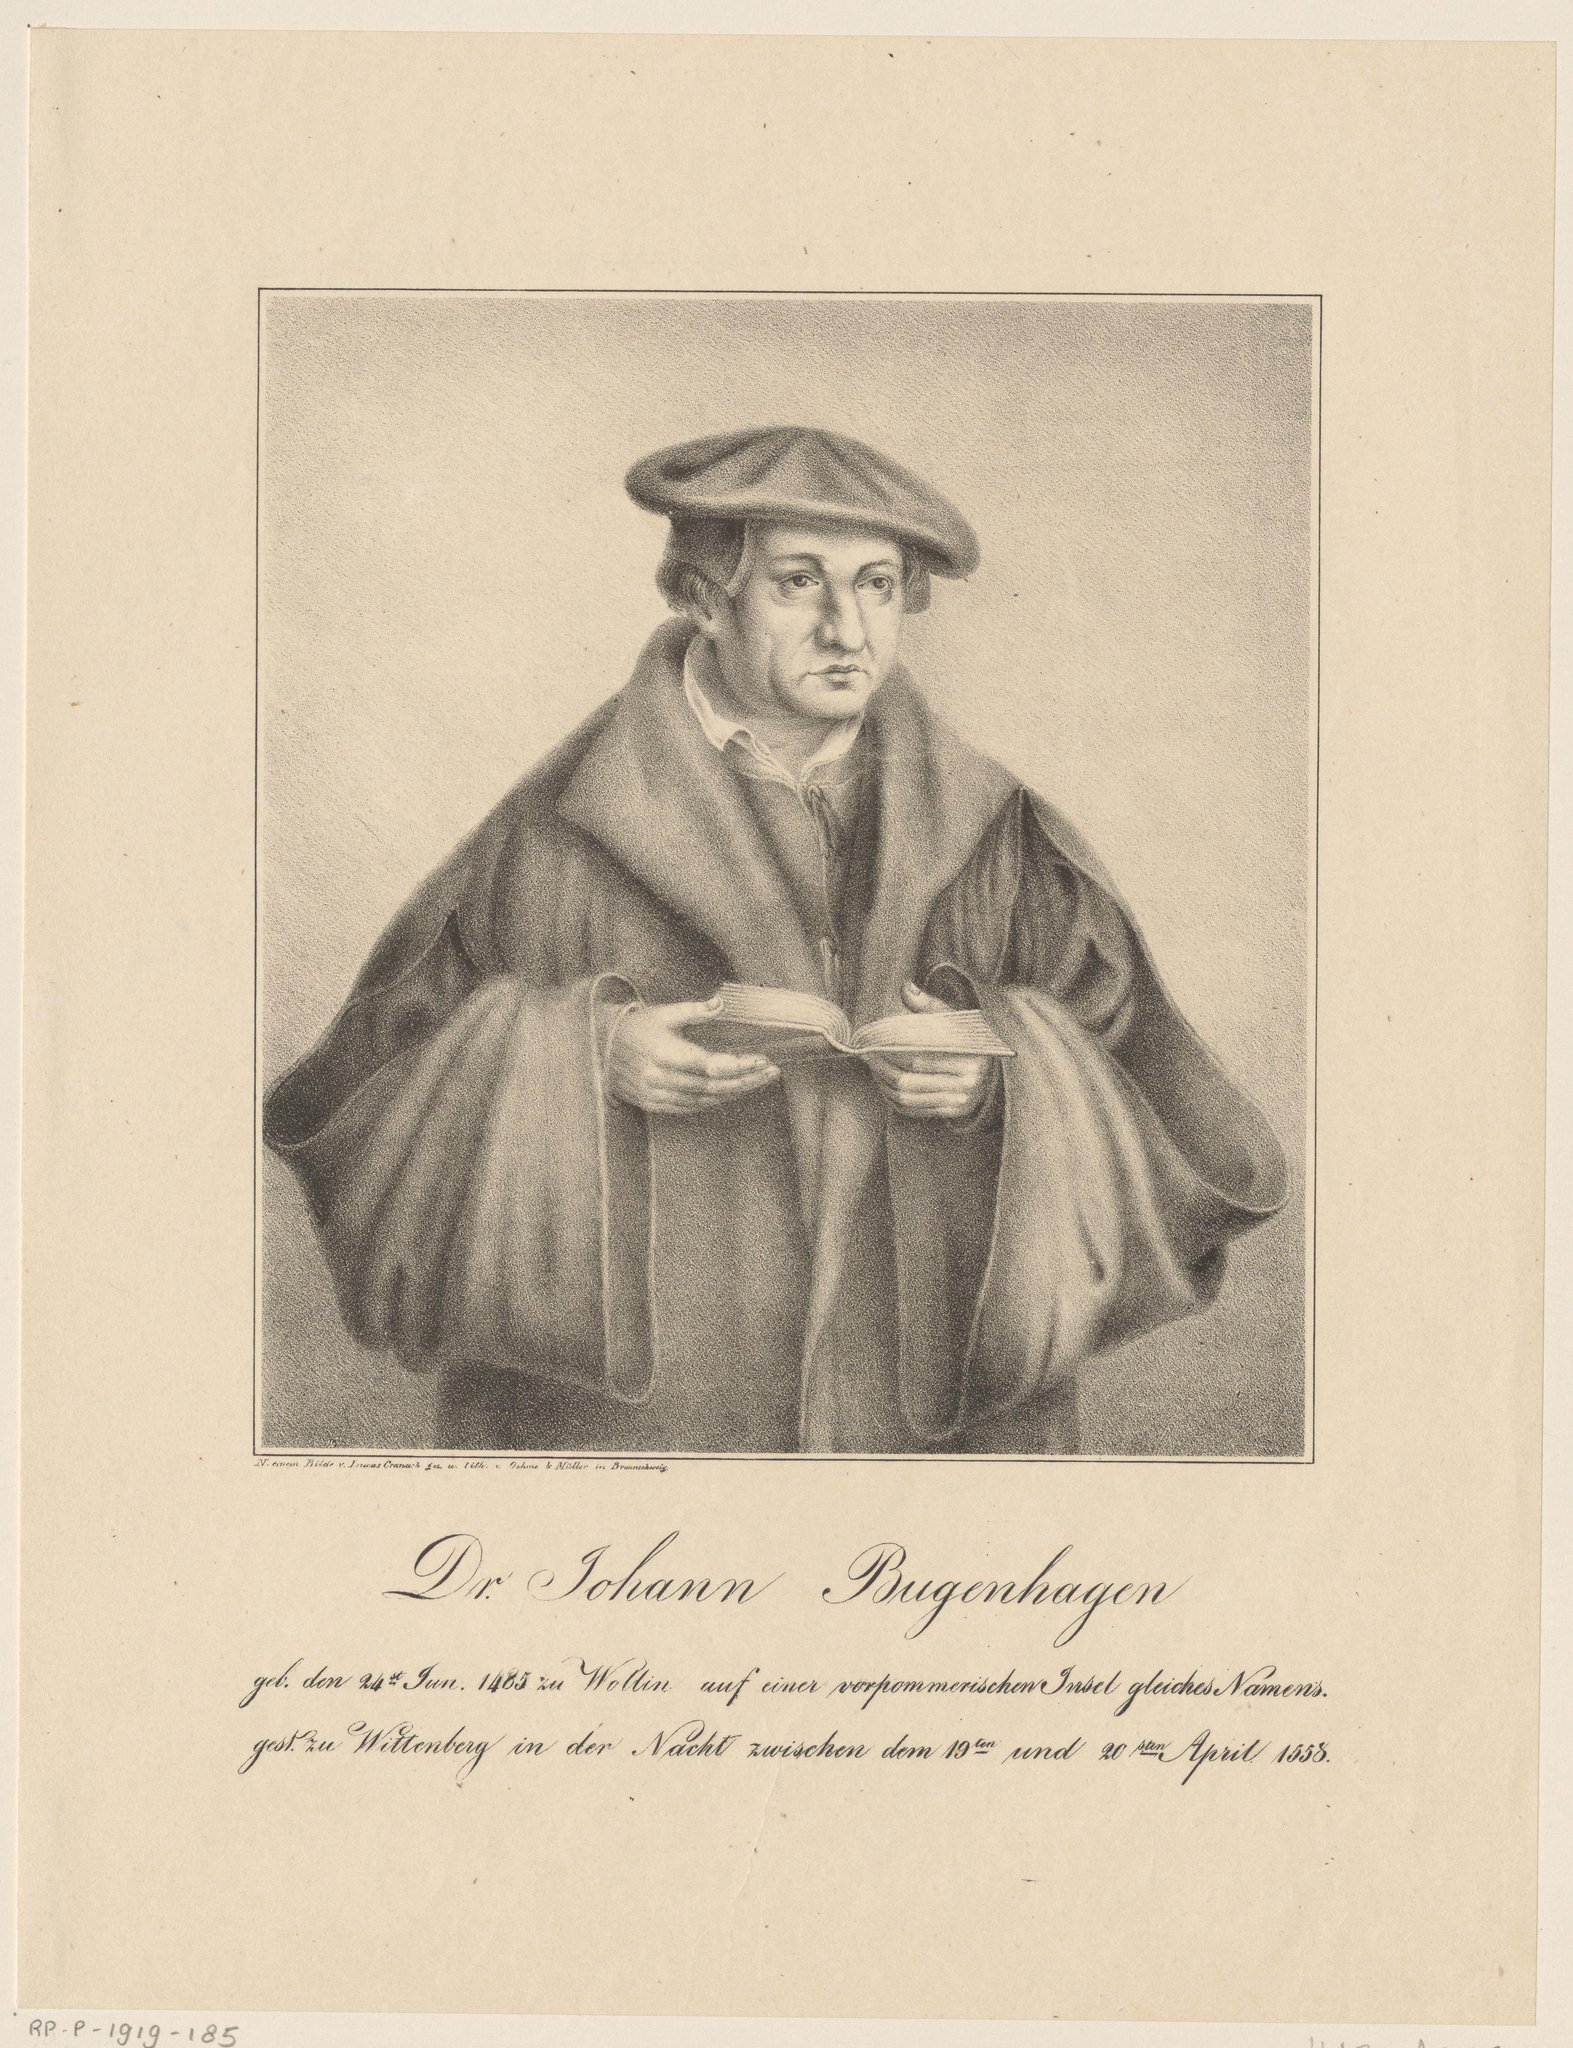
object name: print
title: Portret van Johannes Bugenhagen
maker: lucas cranach (i)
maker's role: draughtsman, print maker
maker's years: 1472-1553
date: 1825-1846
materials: paper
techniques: lithograph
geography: braunschweig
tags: theologian, historical persons, book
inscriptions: collector's mark: Lugt 2228